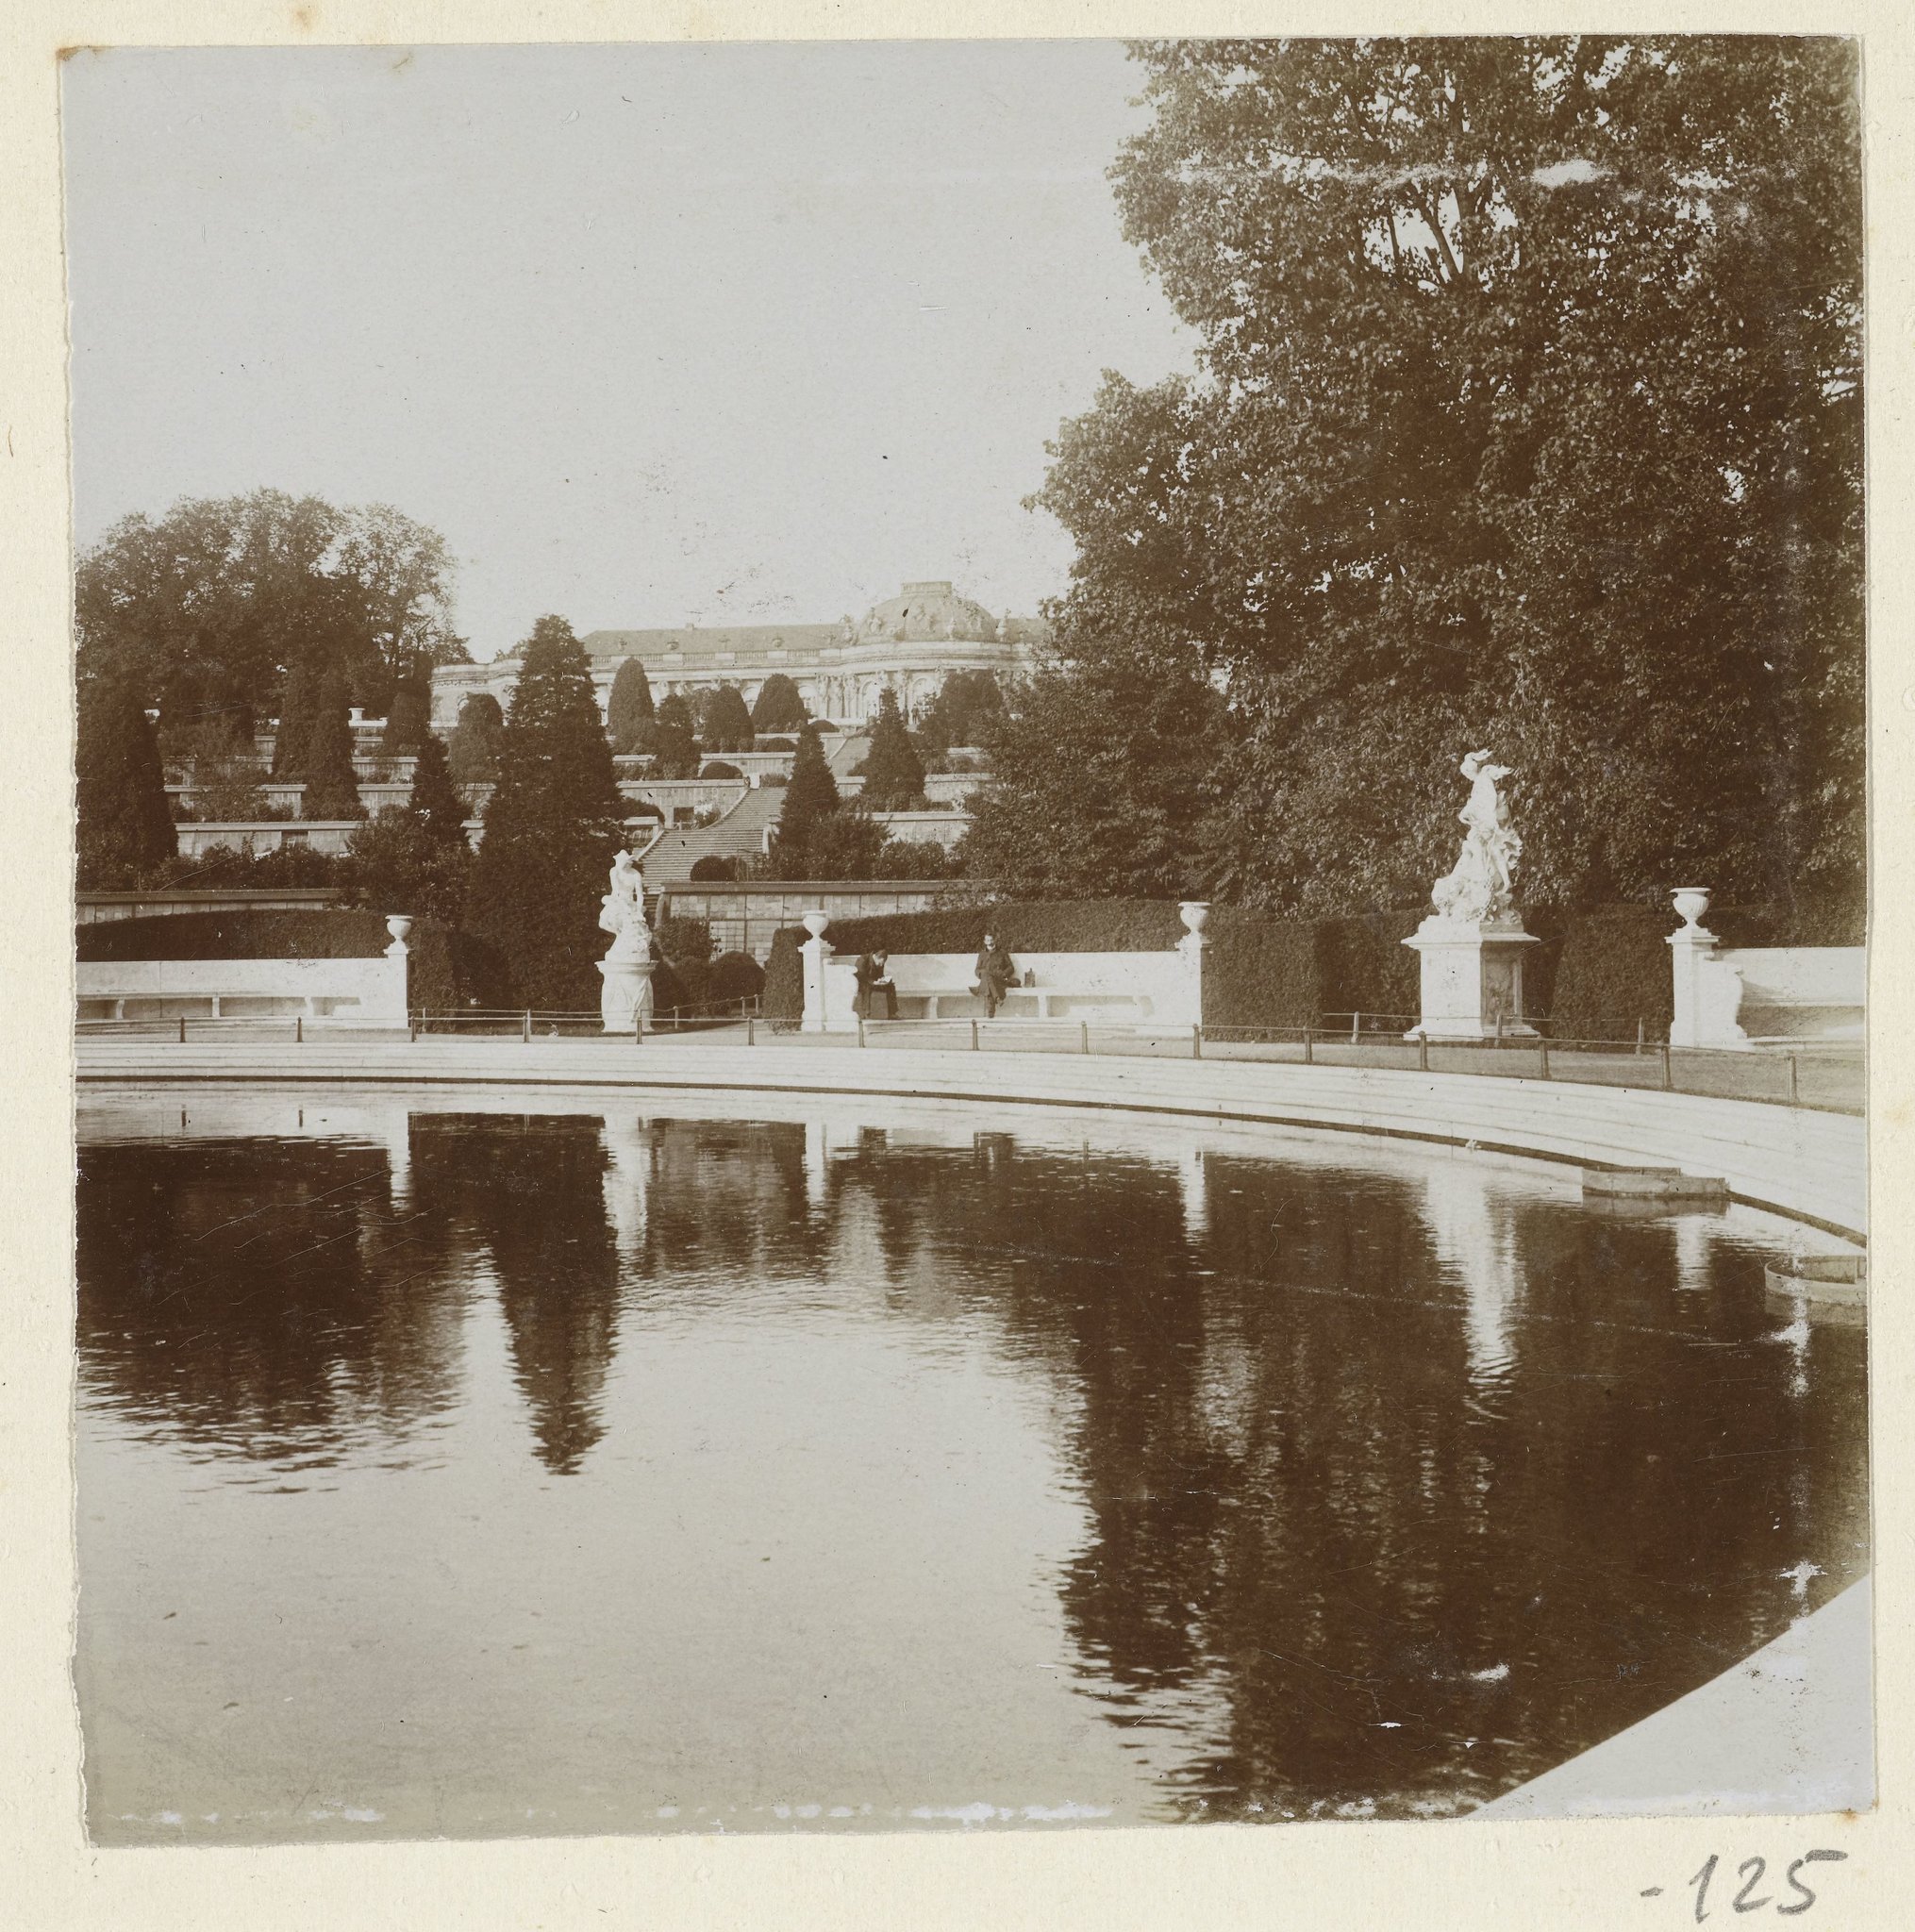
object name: photograph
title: Gezicht op landhuis met een vijver en beelden in vermoedelijk Engeland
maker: geldolph adriaan kessler (dolph)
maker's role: fotograaf, industrieel, voetballer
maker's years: 1884-1945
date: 1903-1904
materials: cardboard, photographic support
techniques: gelatin silver print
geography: england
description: Gezicht op landhuis met een vijver en beelden in vermoedelijk Engeland. Onderdeel van het fotoalbum van Dolph Kessler met opnamen die hij maakte tijdens zijn verblijf in Engeland en op een wereldreis die hij als secretaris van Henri Deterding (directeur Koninklijke Olie) ondernam naar Nederlands-Indië, Japan, China en de Verenigde Staten, tussen 1906 en 1908.